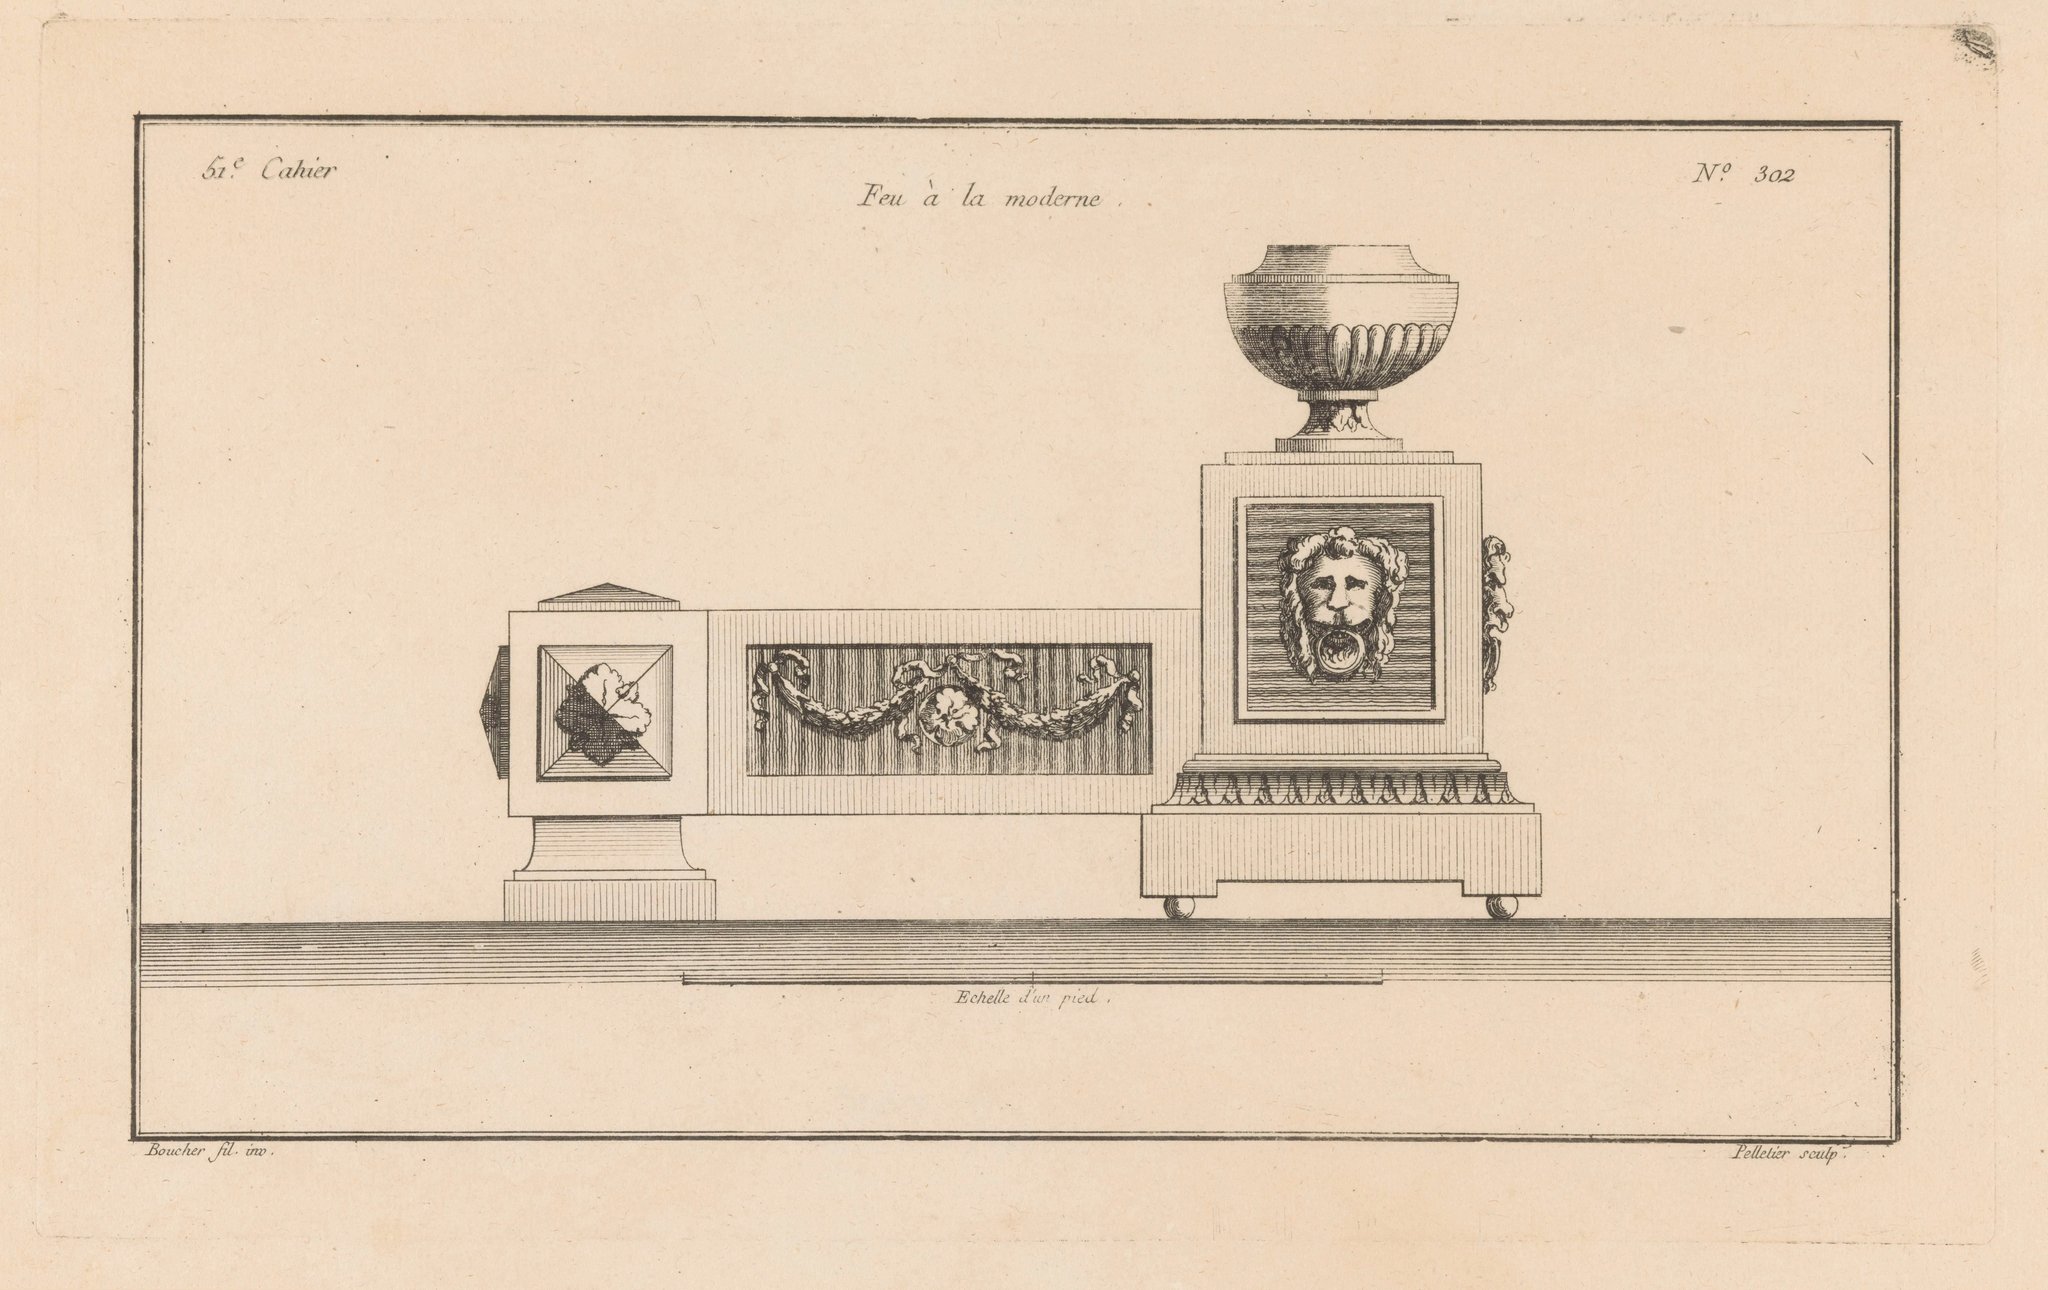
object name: print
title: Vuurbokken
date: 1772-1779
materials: paper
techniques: engraving, etching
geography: paris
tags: lion's head ~ ornament, andiron, fire-dog, vase ~ ornament, ornament ~ festoon, garland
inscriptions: collector's mark: Lugt 2228, collector's mark: Lugt 2760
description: Een geornamenteerde vuurbok met guirlandes, een vaas en leeuwenkoppen. Prentnummer 302.